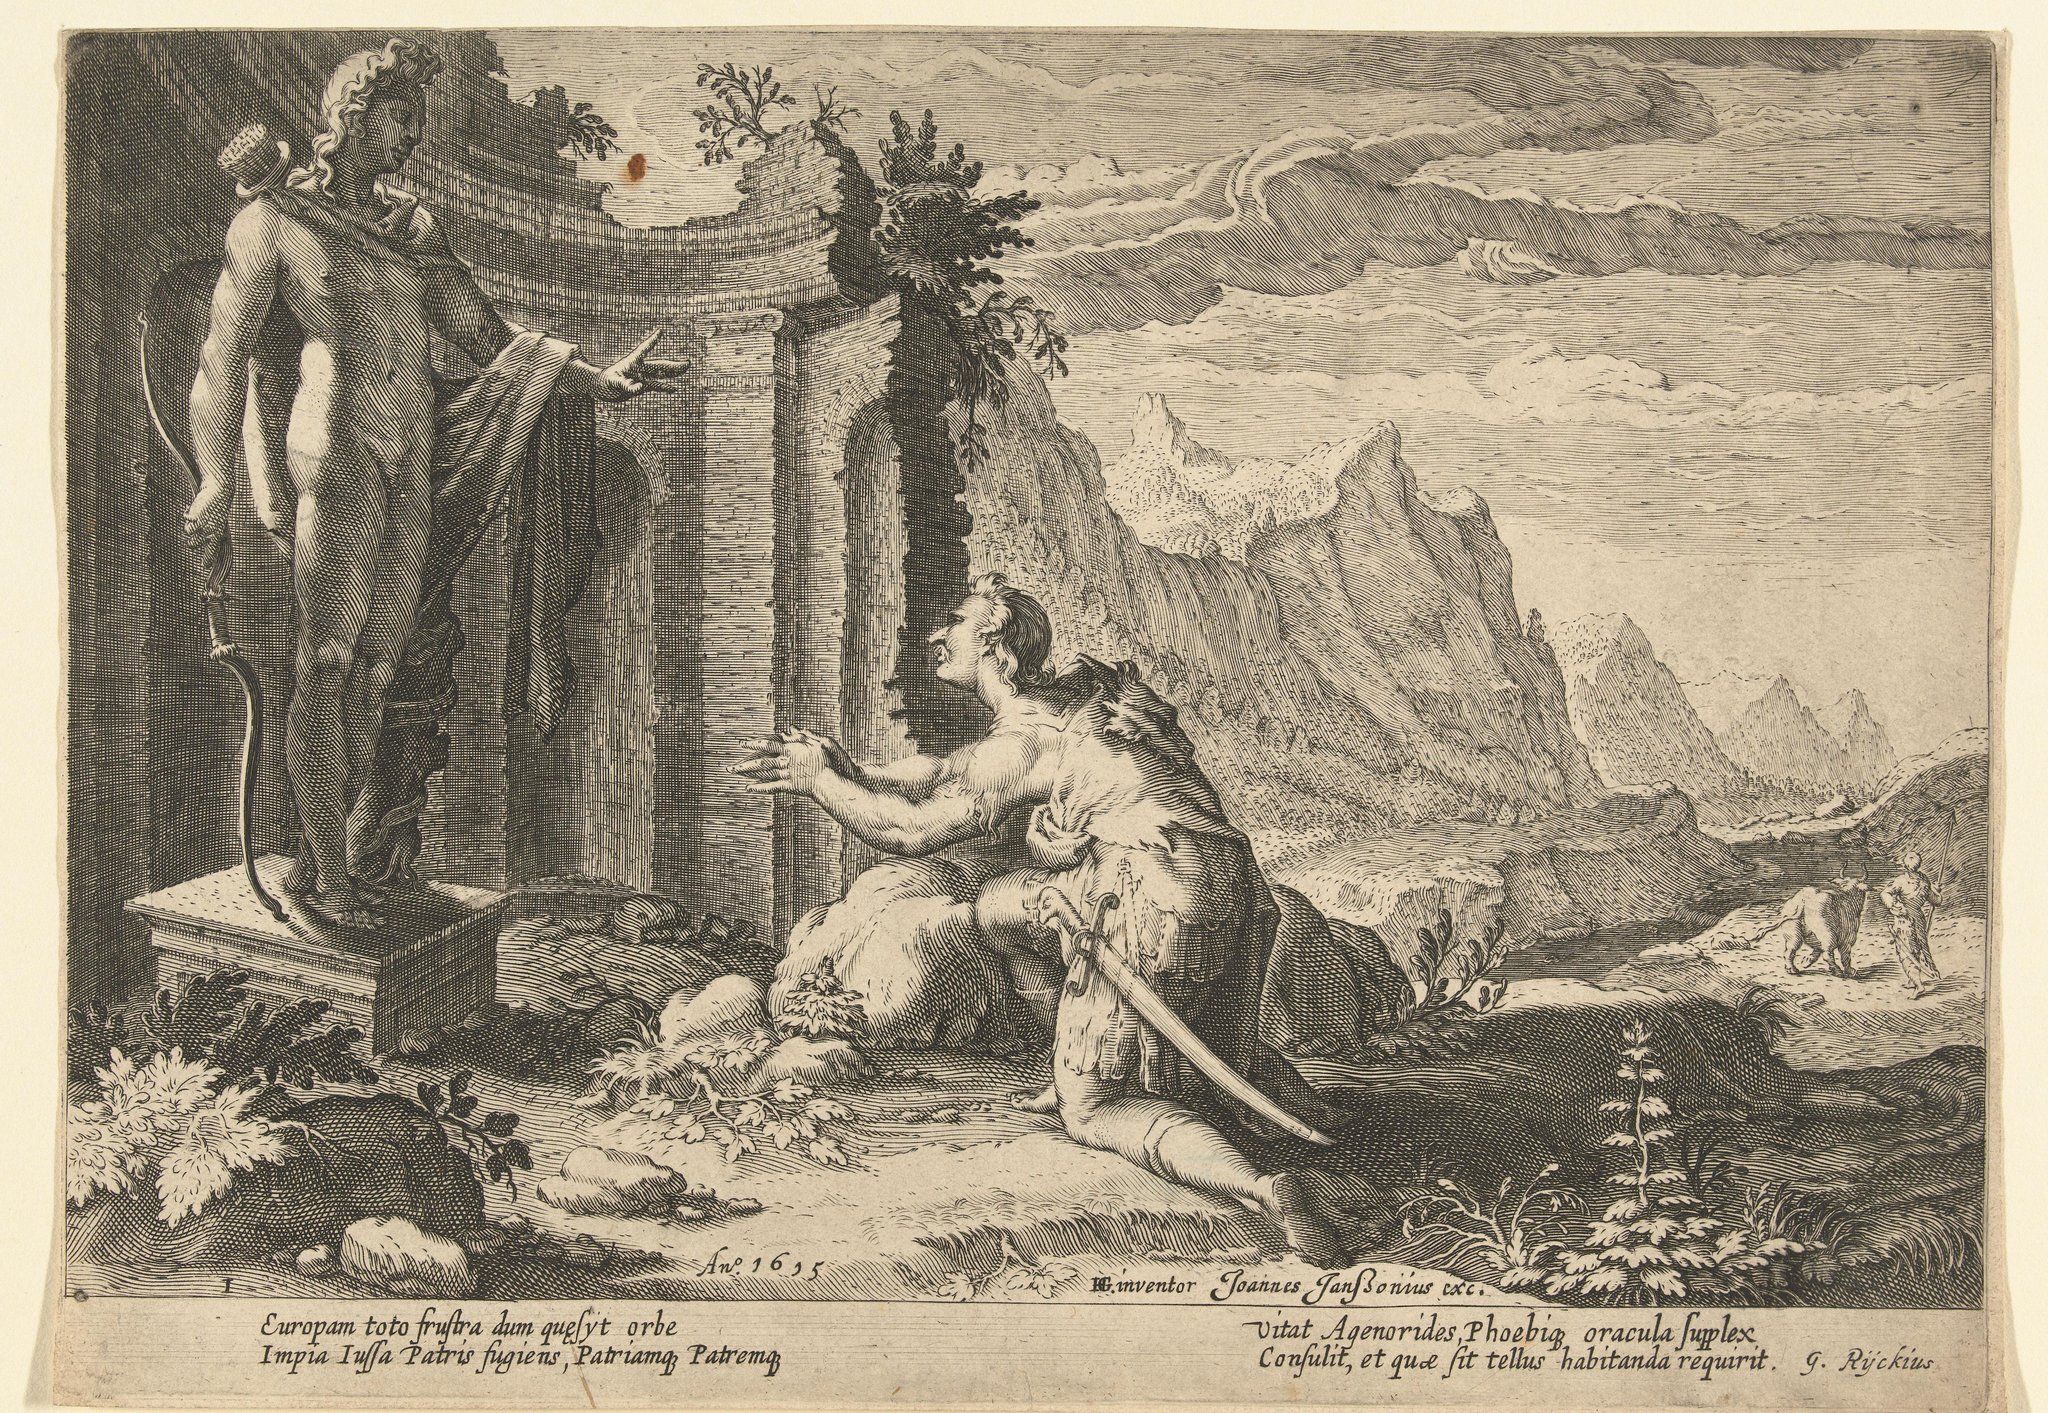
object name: print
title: Ovidius' Metamorfosen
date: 1615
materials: paper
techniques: engraving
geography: haarlem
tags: cadmus meets the cow which leads him into boeotia, cadmus, in search of his sister europa, consults the oracle of apollo at delphi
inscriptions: collector's mark: Lugt 2228a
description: Cadmus, net als zijn broers door zijn vader uitgezonden om zijn zus Europa te zoeken, vraagt het orakel van Delphi wat hem te doen staat, nu hij haar niet heeft kunnen vinden. Het orakel antwoordt dat hij een bepaalde koe voor zich uit moet jagen en op de plaats waar zij gaat liggen een stad moet stichten. Op de voorgrond van de prent knielt Cadmus bij het orakel, op de achtergrond drijft hij de koe voor zich uit. Onder de voorstelling twee keer twee regels Latijnse tekst. Deze prent is onderdeel van een serie van 52 prenten die verhalen uit Ovidius' Metamorfosen verbeelden. Deze serie valt uiteen in drie genummerde reeksen: twee van 20 prenten en één van 12 prenten. Deze prent behoort tot de derde reeks.